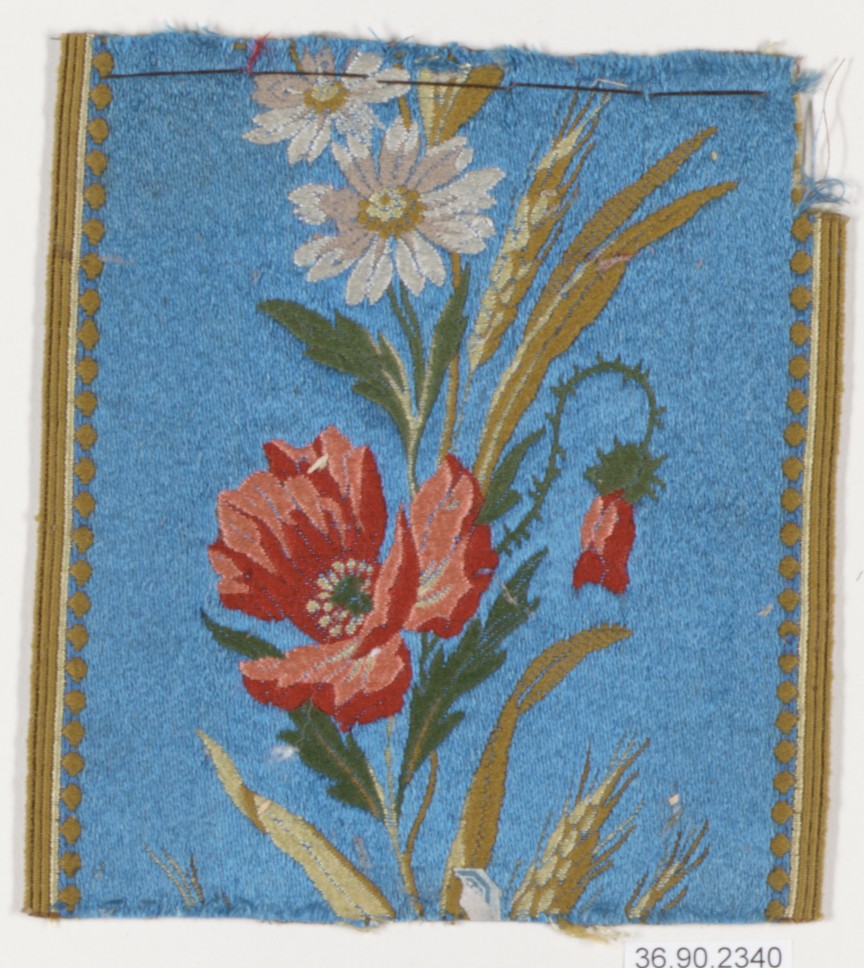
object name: piece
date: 1801-1900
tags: flowers,leaves